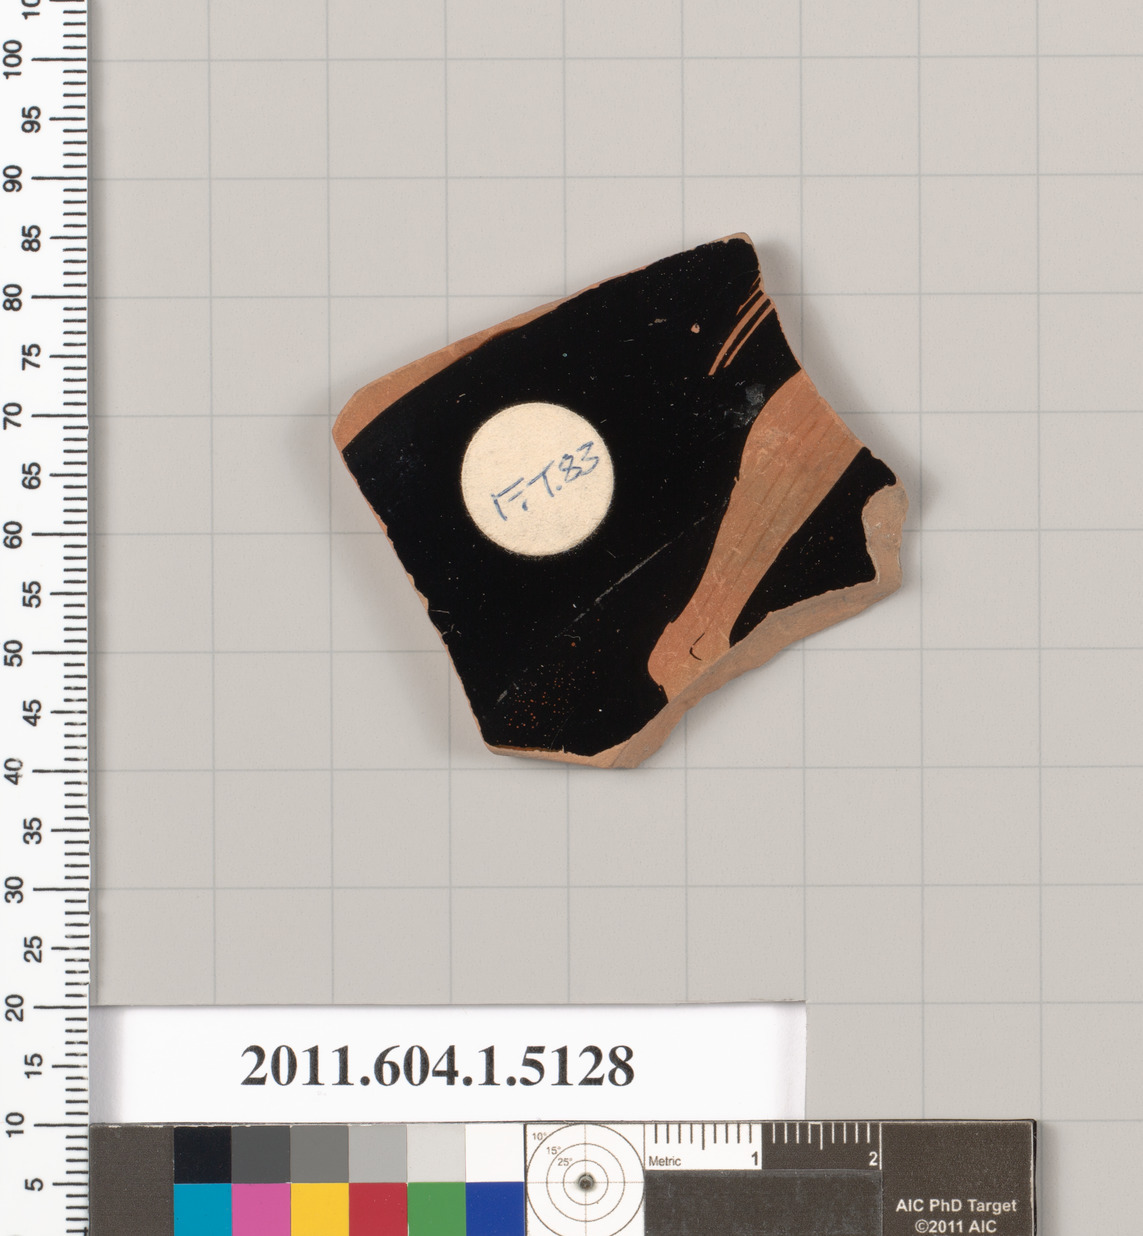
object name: kylix fragment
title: Terracotta fragment of a kylix (drinking cup)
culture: greek, attic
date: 490-480 BCE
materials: terracotta